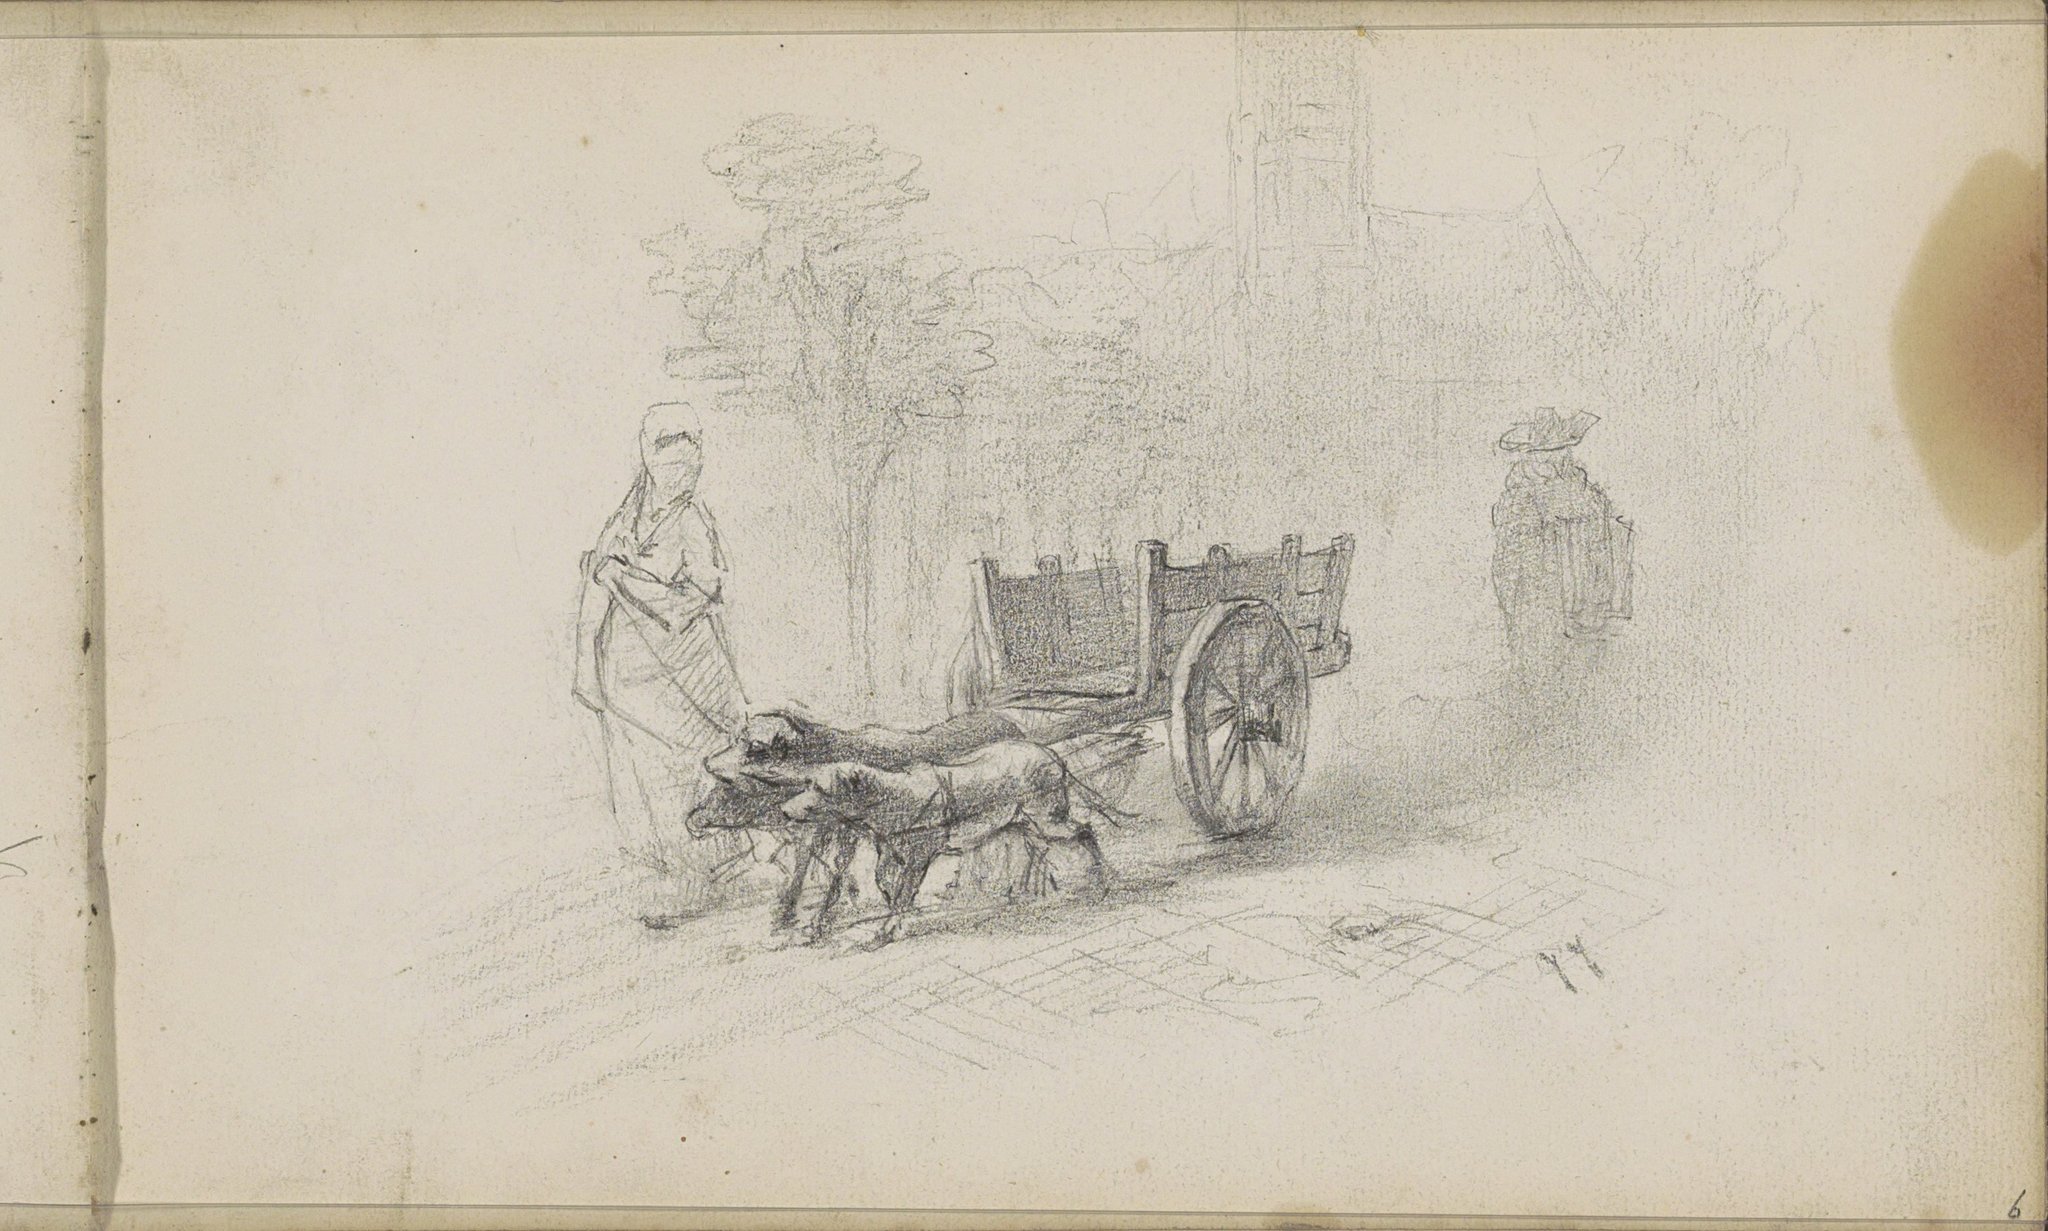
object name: sketchbook leaf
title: Gesluierde figuur met een hondenkar op een pad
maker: willem cornelis rip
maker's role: draughtsman, painter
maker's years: 1856-1922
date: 1877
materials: paper, pencil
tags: animal traction, animal-drawn vehicle (carriage etc.), street (+ city(-scape) with figures, staffage)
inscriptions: date: ‘77’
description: Op het pad staat een man met een hoed. Op de achtergrond de contouren van een kerk. Blad 6 recto uit een schetsboek met 41 bladen.